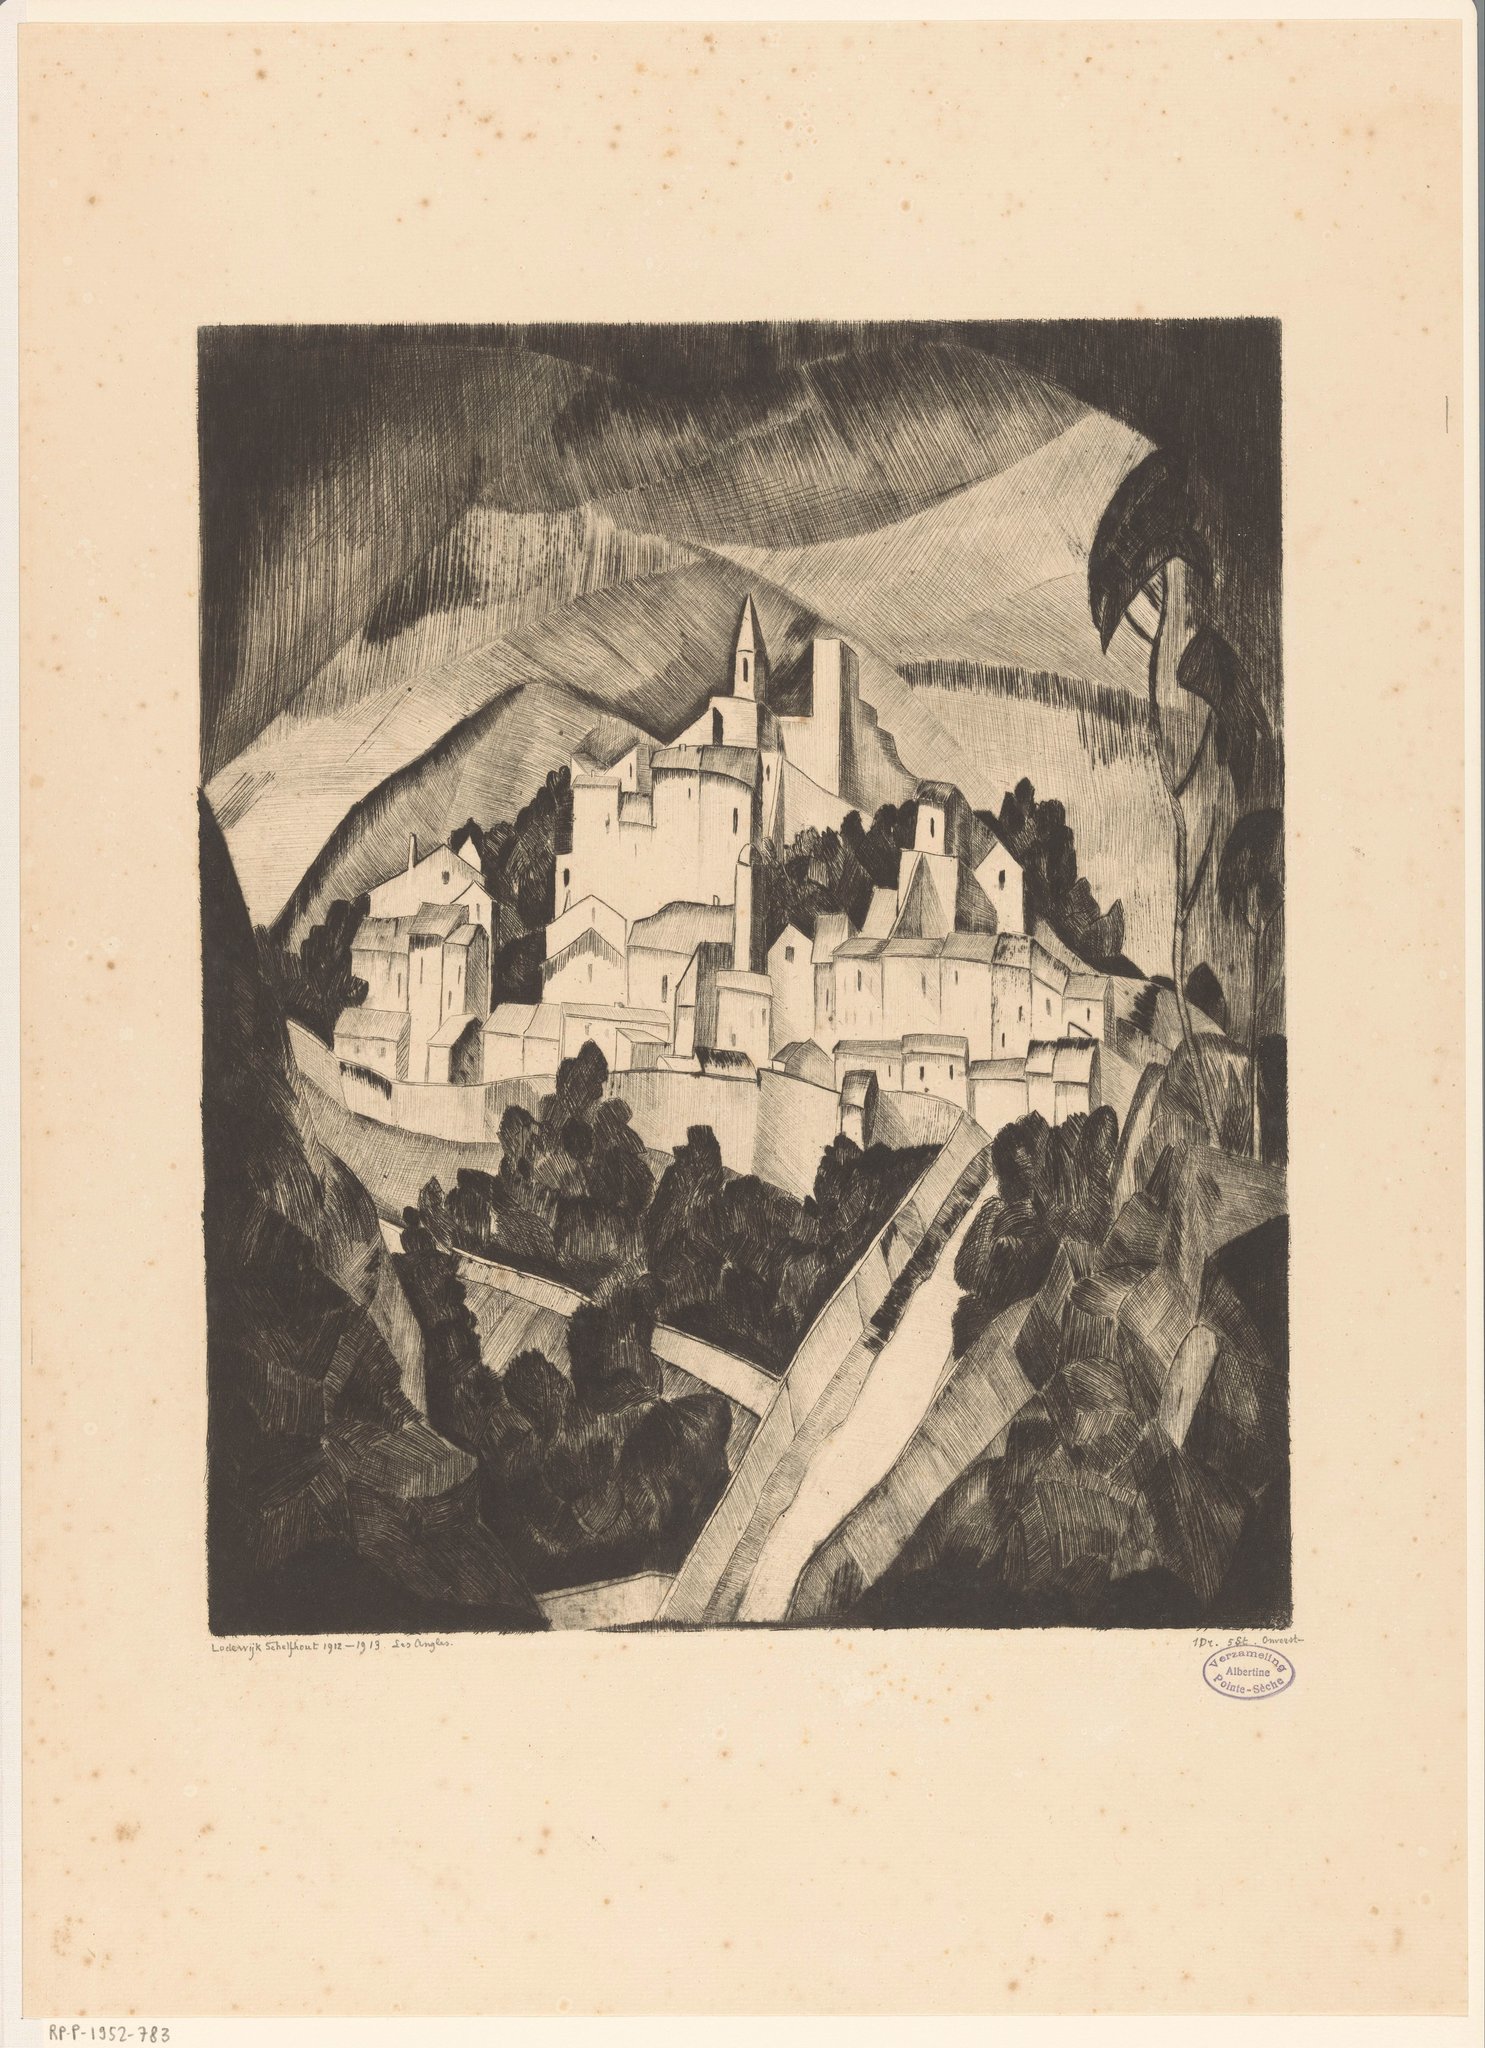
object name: print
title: Les Angles I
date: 1912-1913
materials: paper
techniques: drypoint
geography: netherlands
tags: low hill country, village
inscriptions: collector's mark: Lugt 2228, collector's mark: Lugt 2760, collector's mark: Lugt 5i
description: Het dorp Les Angles, gelegen op een heuvel nabij de stad Avignon in het zuiden van Frankrijk.